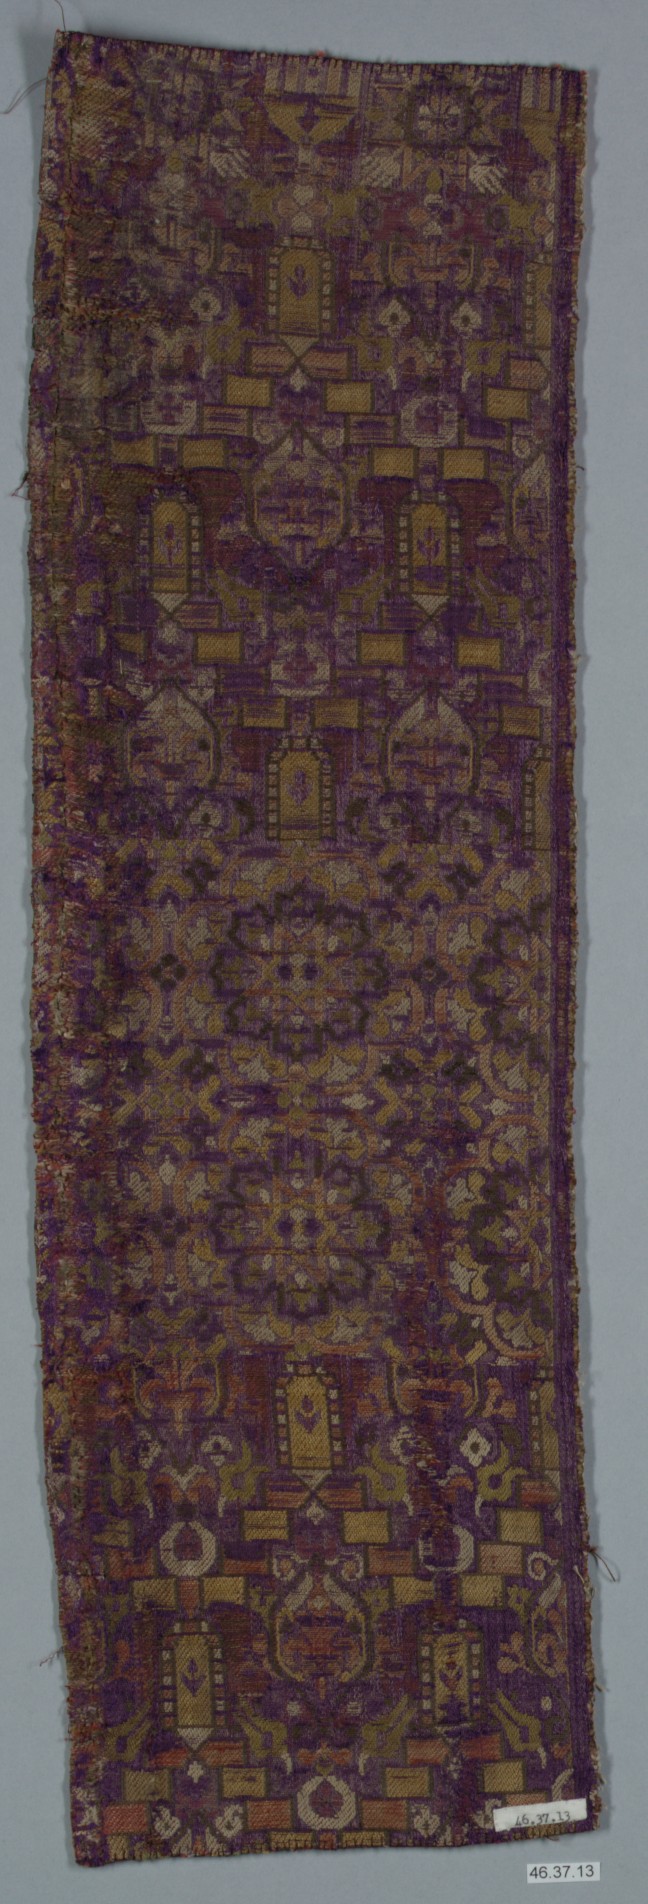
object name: textile fragment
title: Fragment of Sash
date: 1701-1800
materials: silk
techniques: weave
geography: morocco